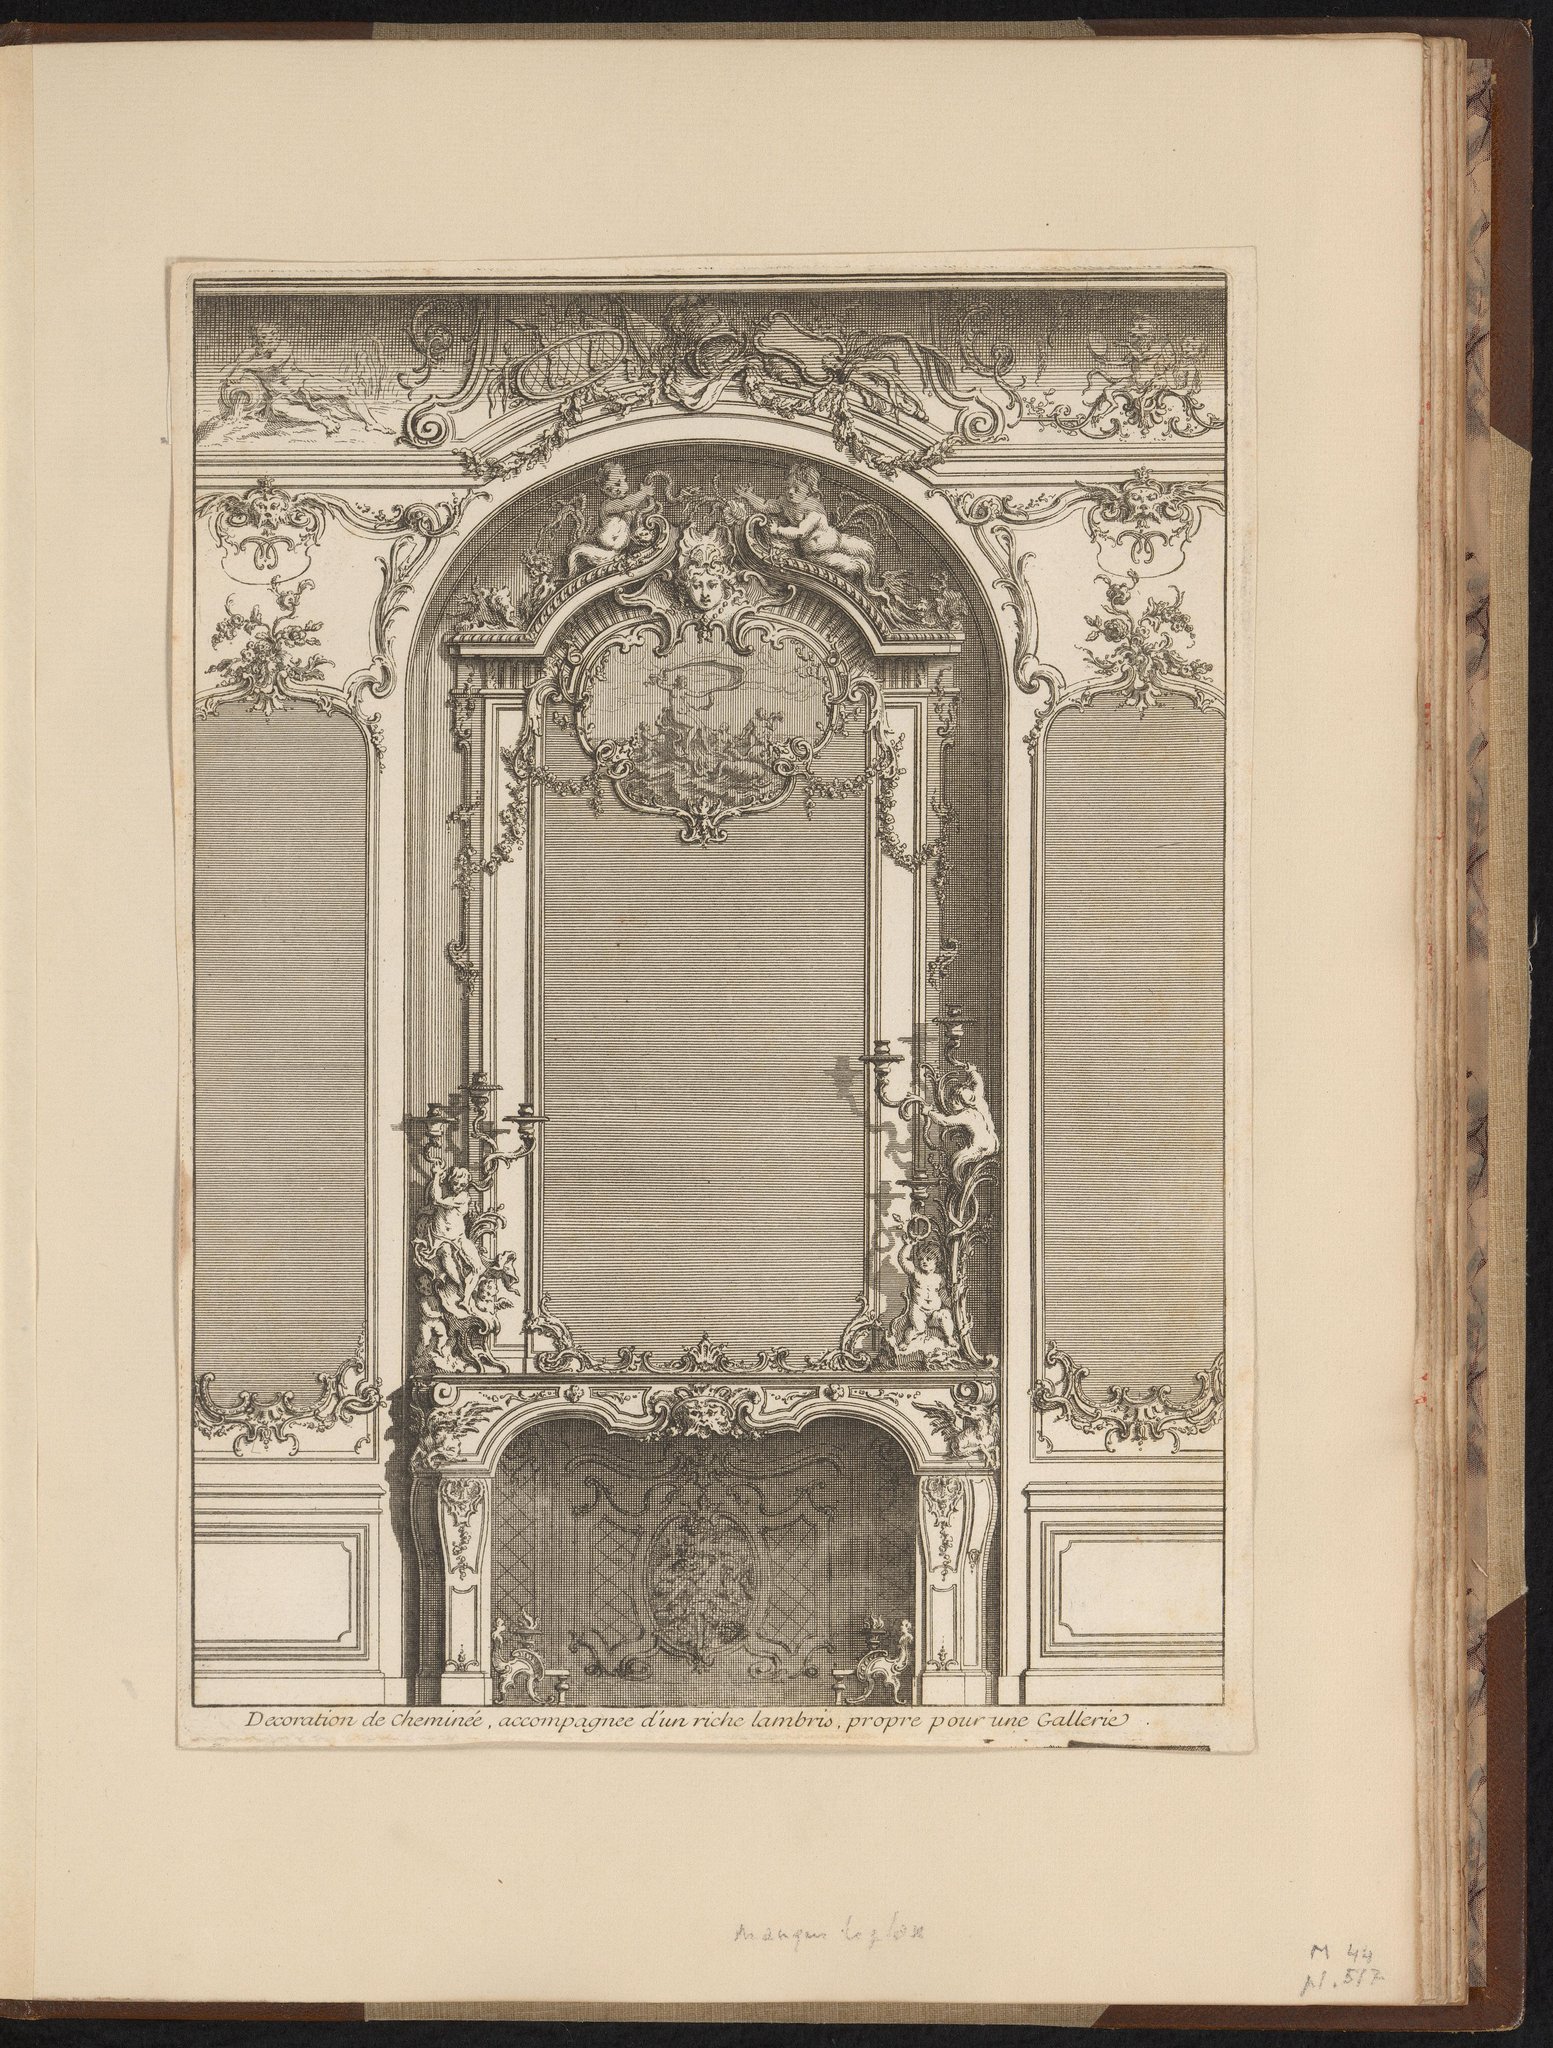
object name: album leaf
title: Decoration de cheminée, accompagnee d'un richte lambris, propre pour une gallerie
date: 1725-1750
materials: paper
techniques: etching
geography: paris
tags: ornaments ~ art, panelling, ornament ~ candelabrum, chimney-piece, mantelpiece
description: Deze prent maakt deel uit van een album.